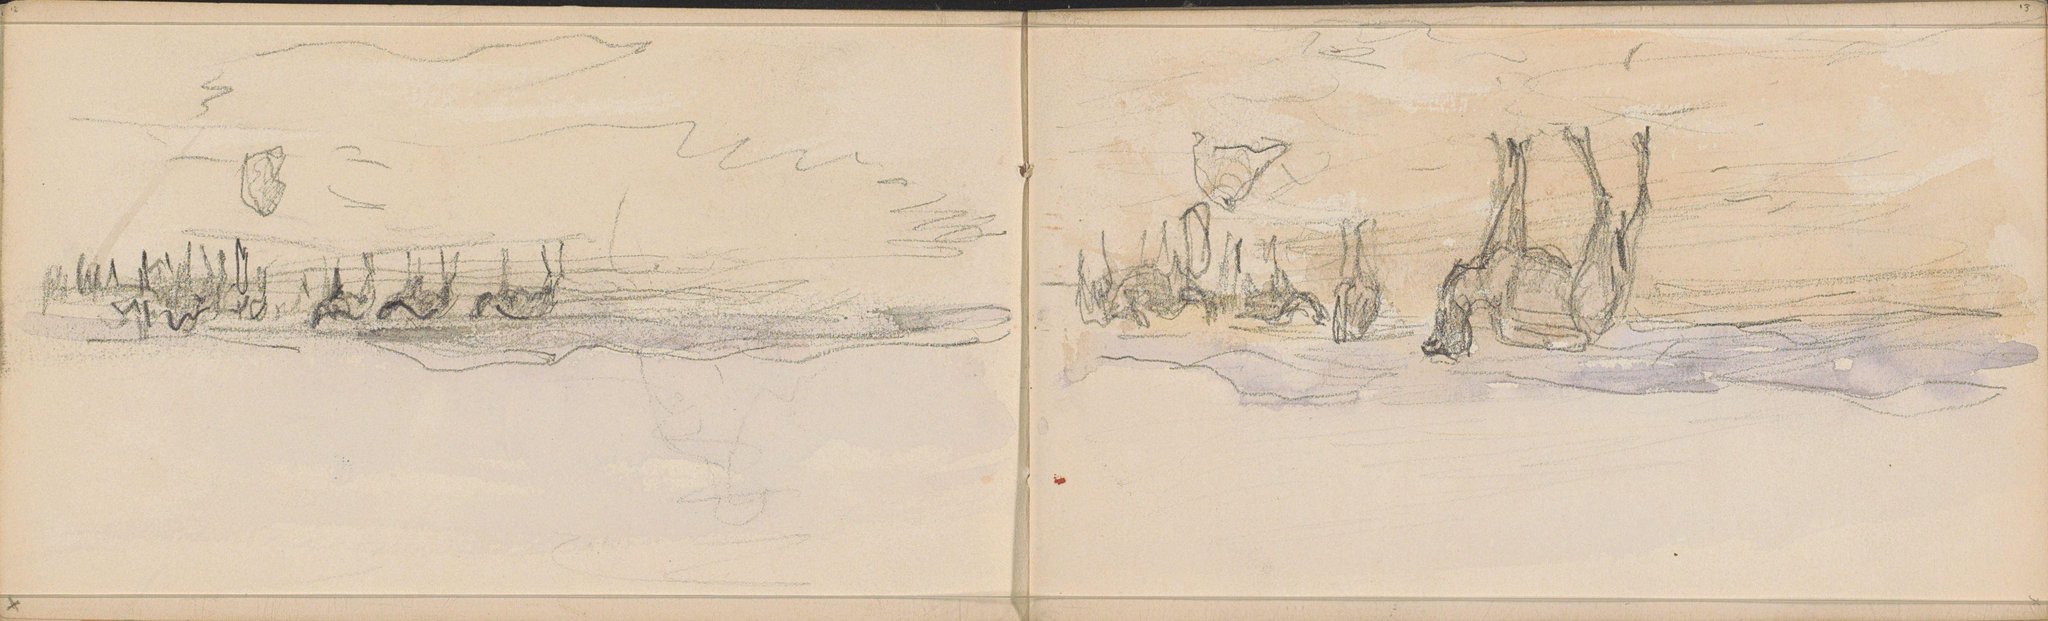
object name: sketchbook leaf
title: Woestijnlandschap met kamelen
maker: marius bauer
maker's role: draughtsman, print maker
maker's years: 1867-1932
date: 1922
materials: paper, pencil, watercolor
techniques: brush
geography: biskra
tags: hoofed animals: camel, desert, mountains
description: Op de achtergrond vermoedelijk het Atlasgebergte. Pagina 12 en 13 uit een schetsboek met 31 bladen.